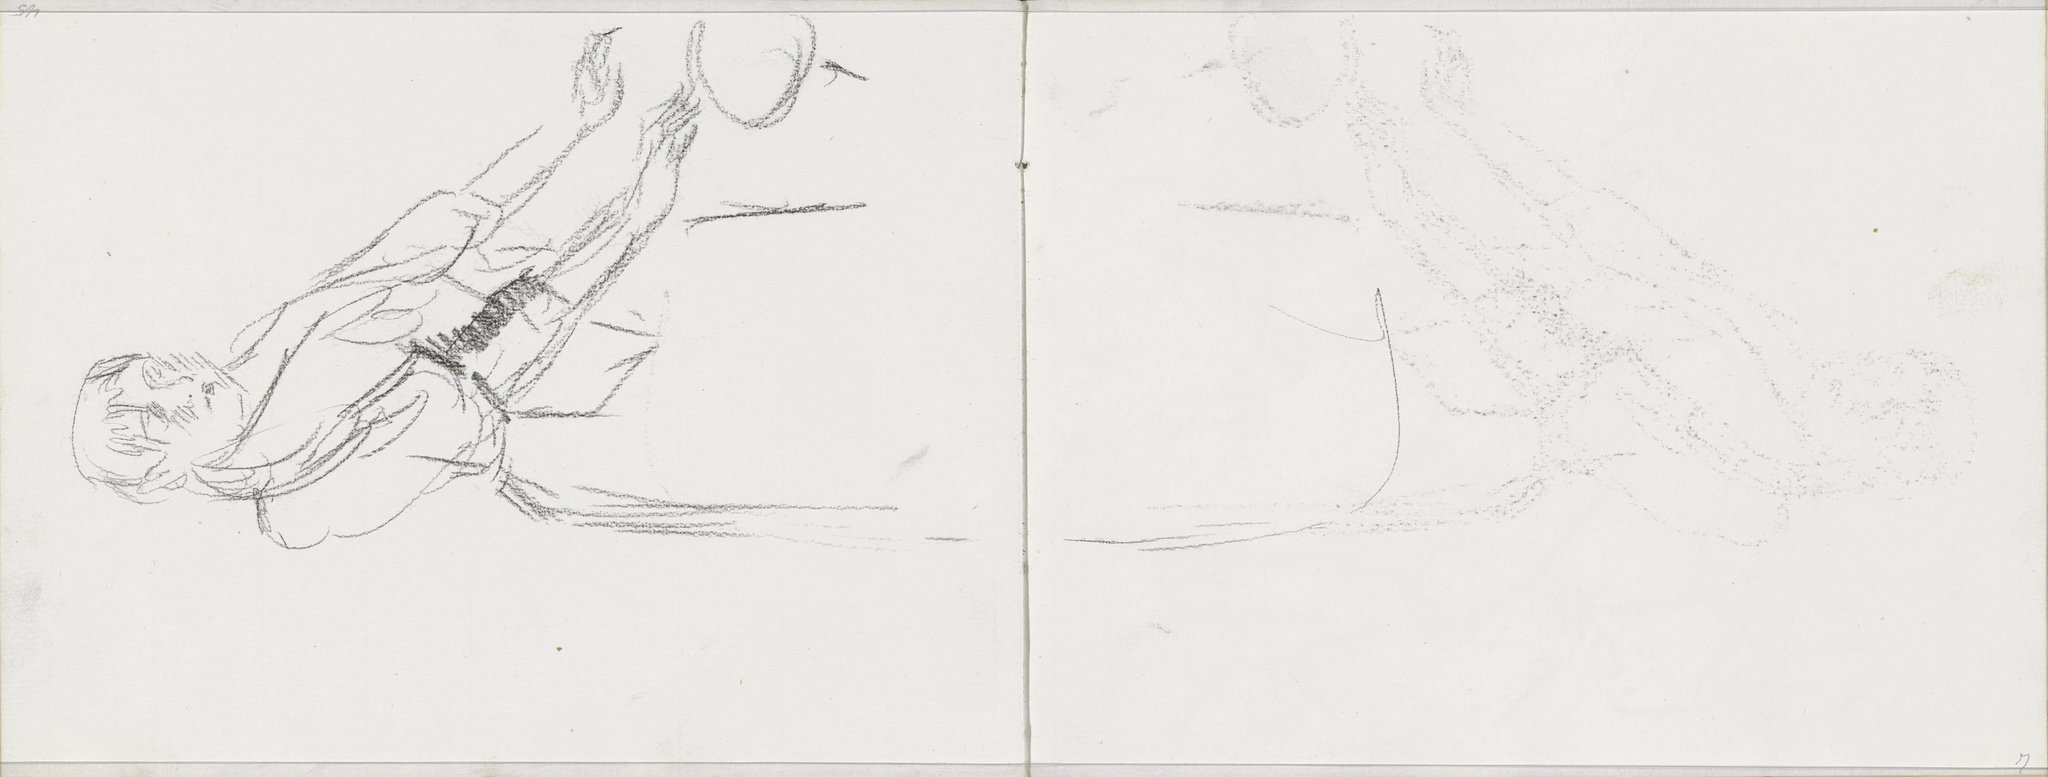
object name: sketchbook leaf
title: Staande vrouw met gestrekte armen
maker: isaac israels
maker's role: draughtsman, painter, print maker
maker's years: 1865-1934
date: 1875-1934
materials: chalk, paper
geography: amsterdam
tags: arm stretched forward - aa - both arms or hands, adult woman (+ standing)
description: Blad 6 verso en blad 7 recto uit schetsboek XX met 26 bladen.